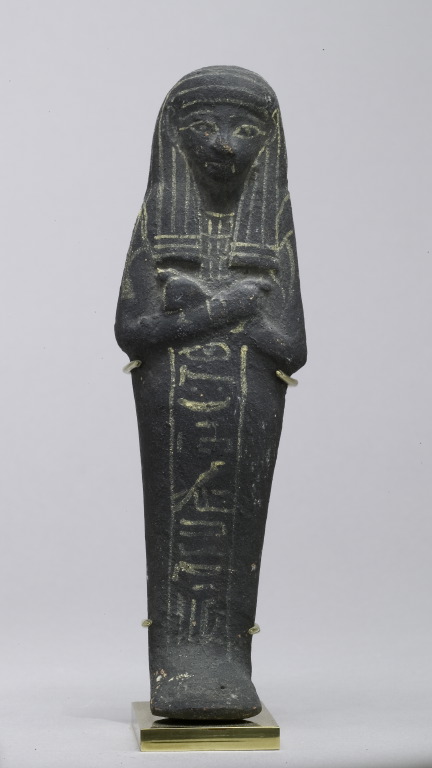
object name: shabti, tamaket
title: Shabti of Tamaket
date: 1279-1213 BCE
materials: paint, pottery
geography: egypt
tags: hieroglyphs